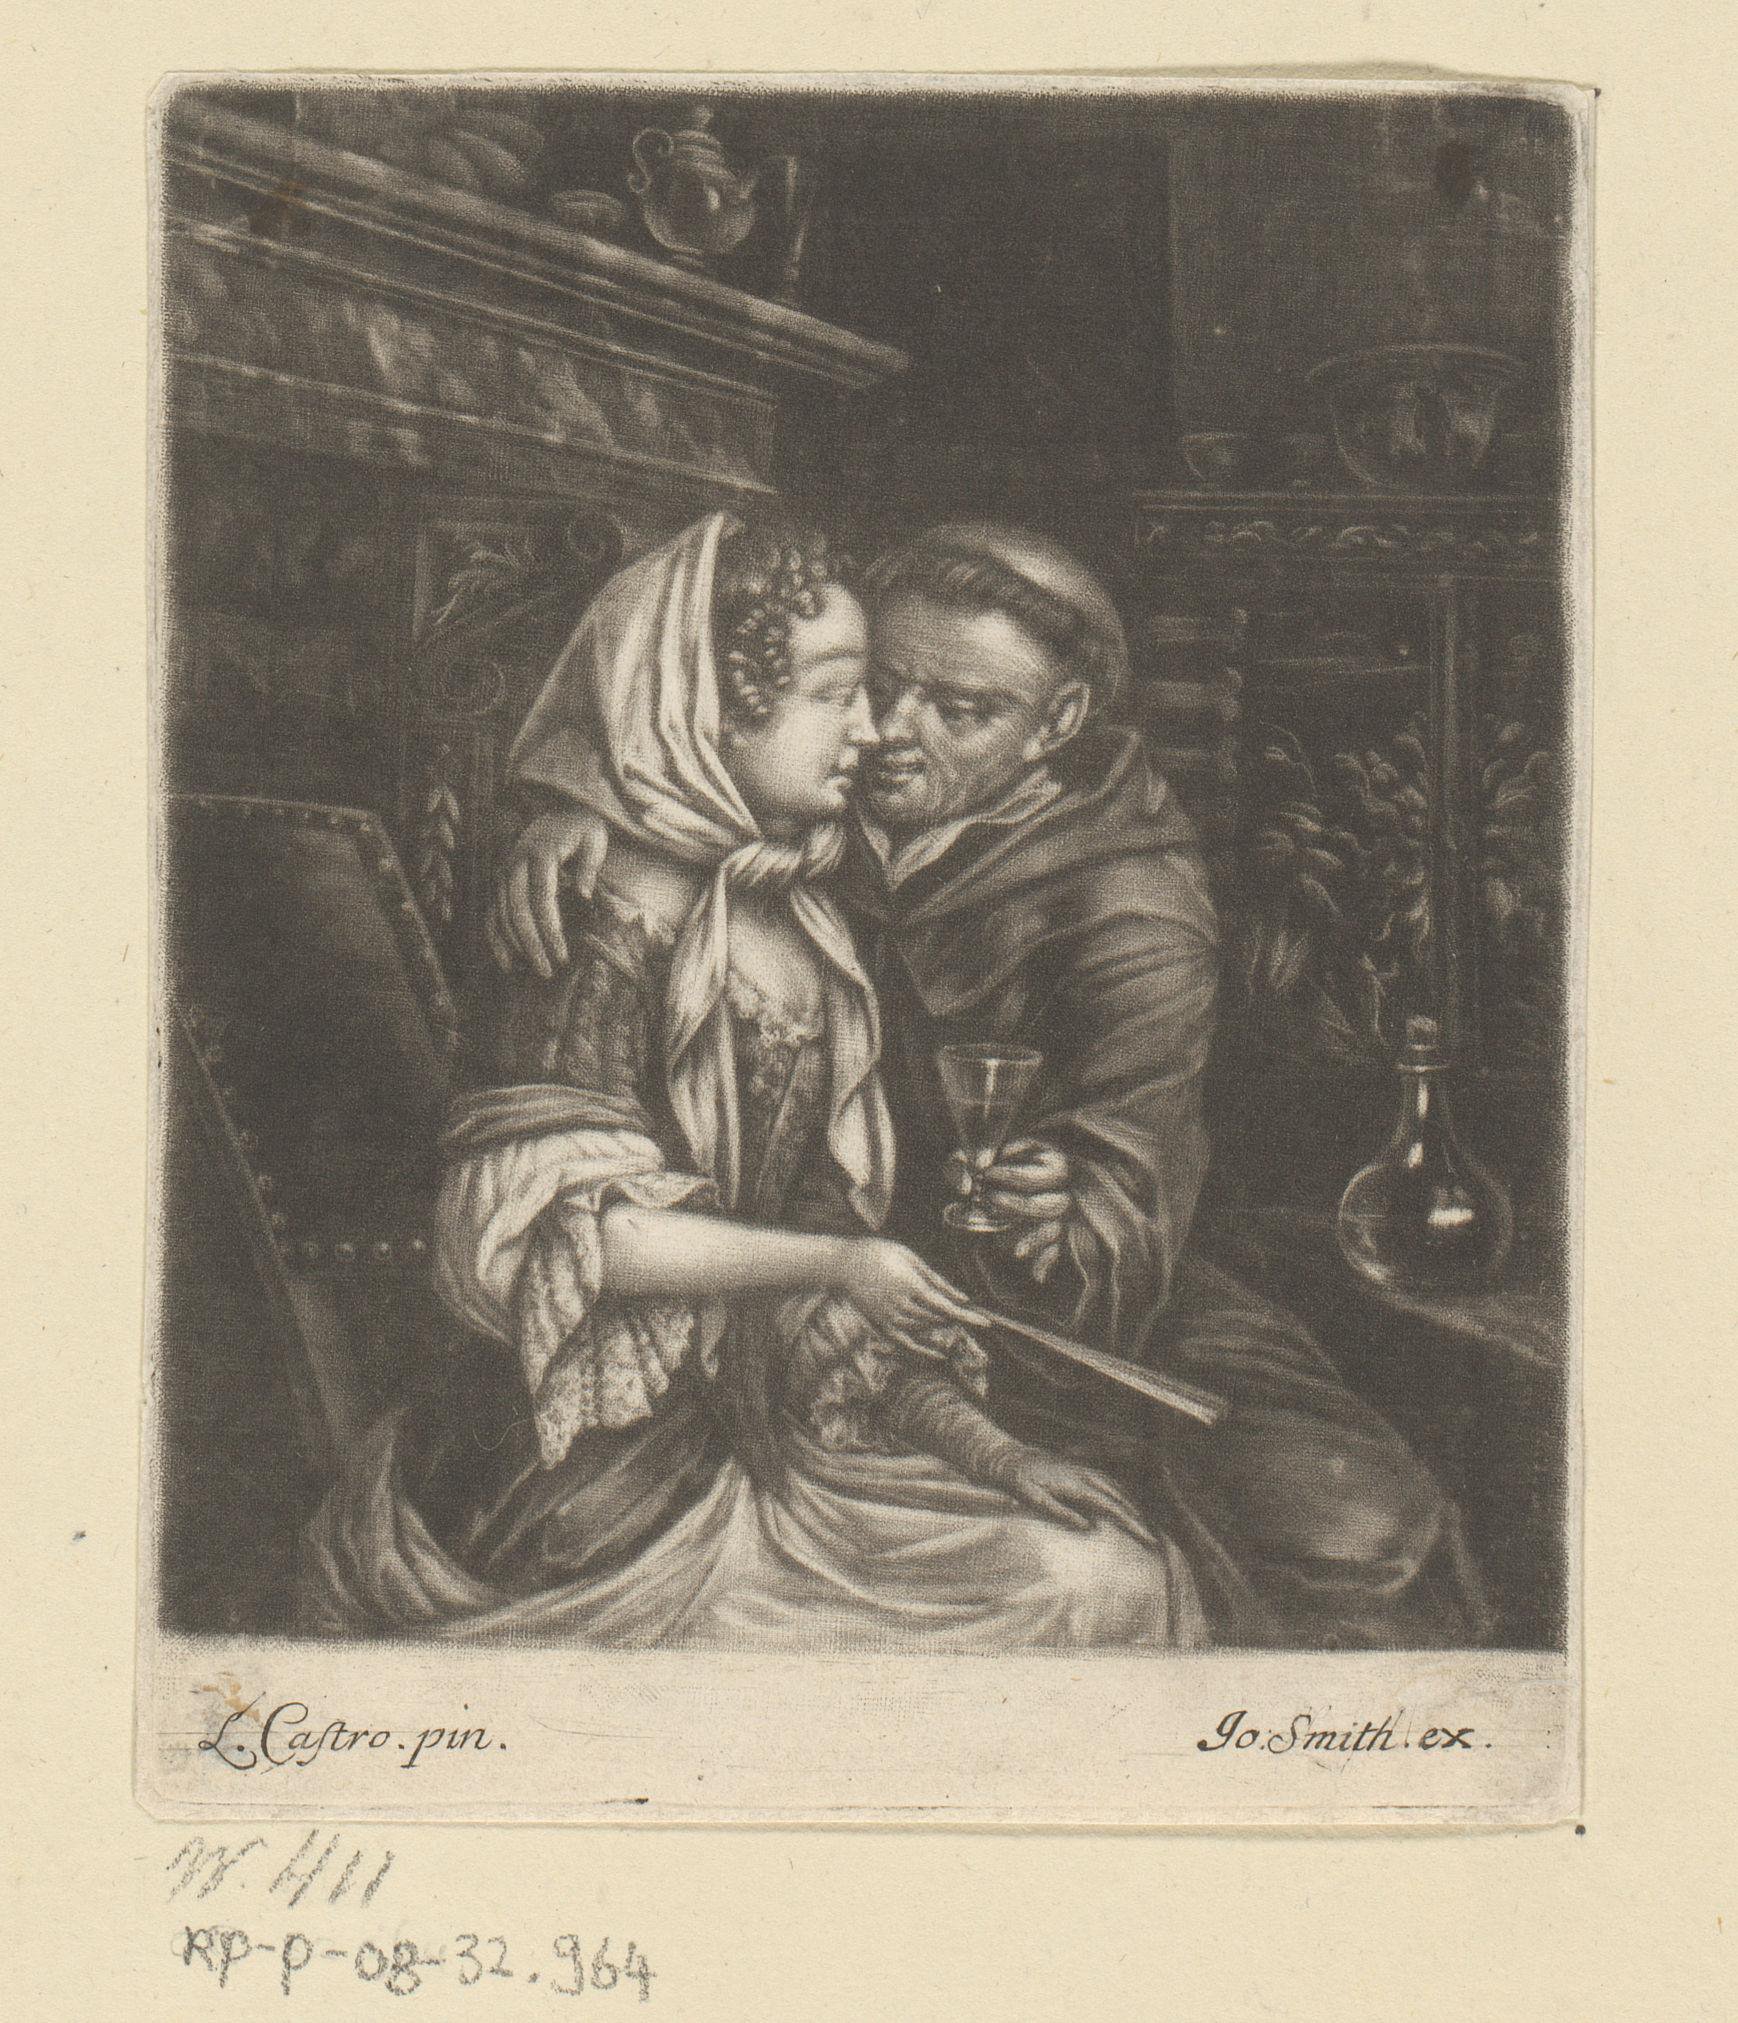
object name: print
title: Monnik verleidt een vrouw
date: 1662-1742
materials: paper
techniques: mezzotint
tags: monk(s), friar(s), giving drink, hotel, hostelry, inn, lovers; courting, flirting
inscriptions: collector's mark: Lugt 240